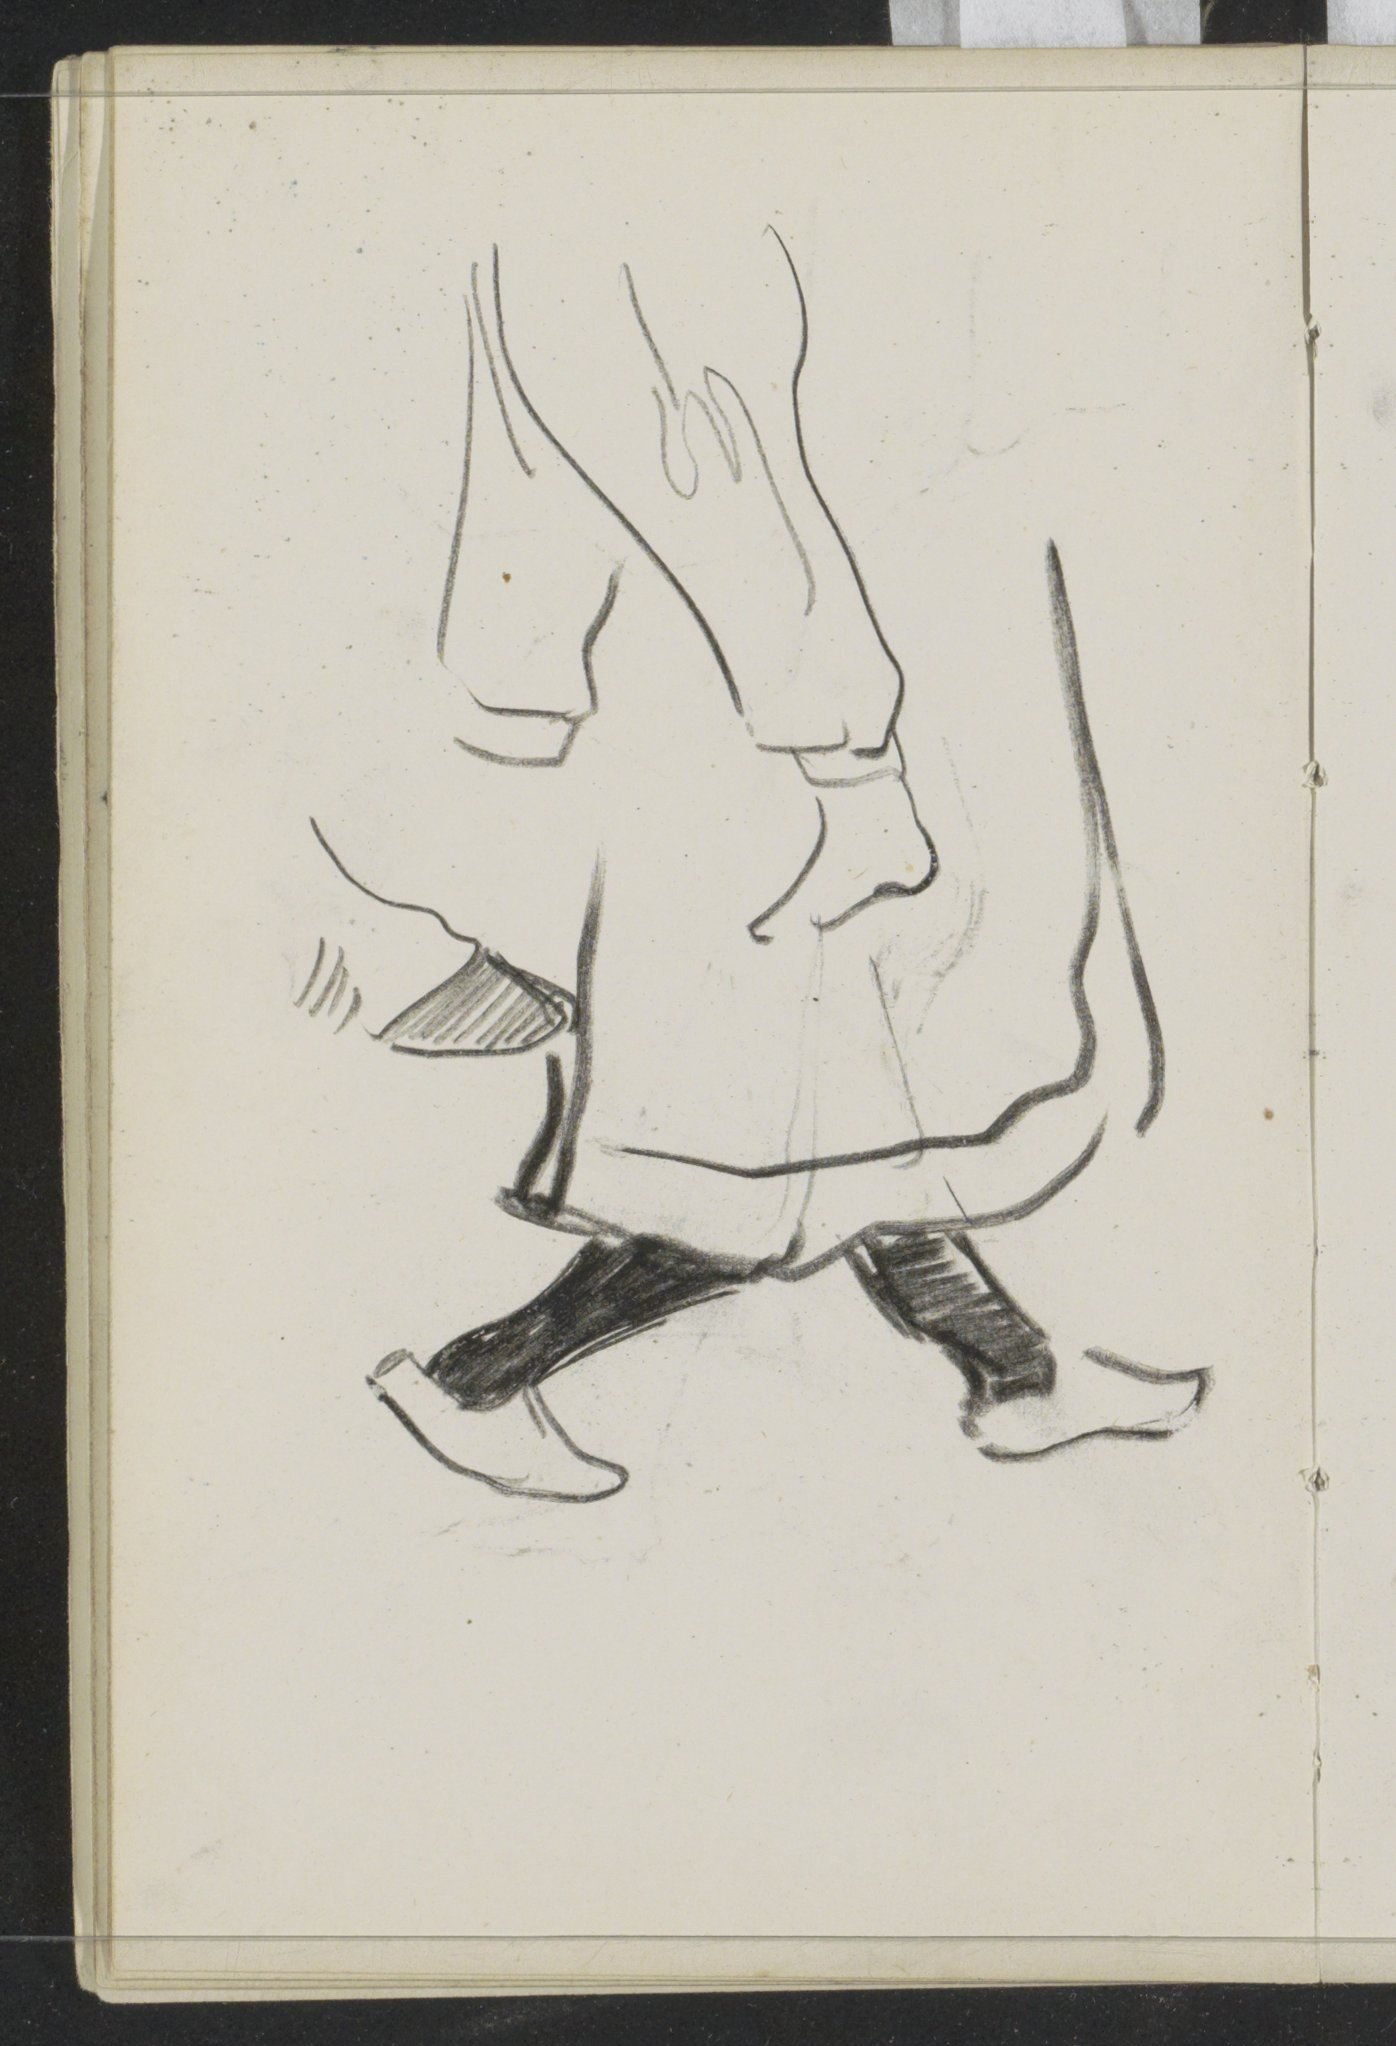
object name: sketchbook leaf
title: Lopende benen van een man en vrouw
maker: carel adolph lion cachet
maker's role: draughtsman, print maker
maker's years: 1864-1945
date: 1874-1945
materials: chalk, paper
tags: legs, walking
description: Blad 20 verso uit een schetsboek met 41 bladen.